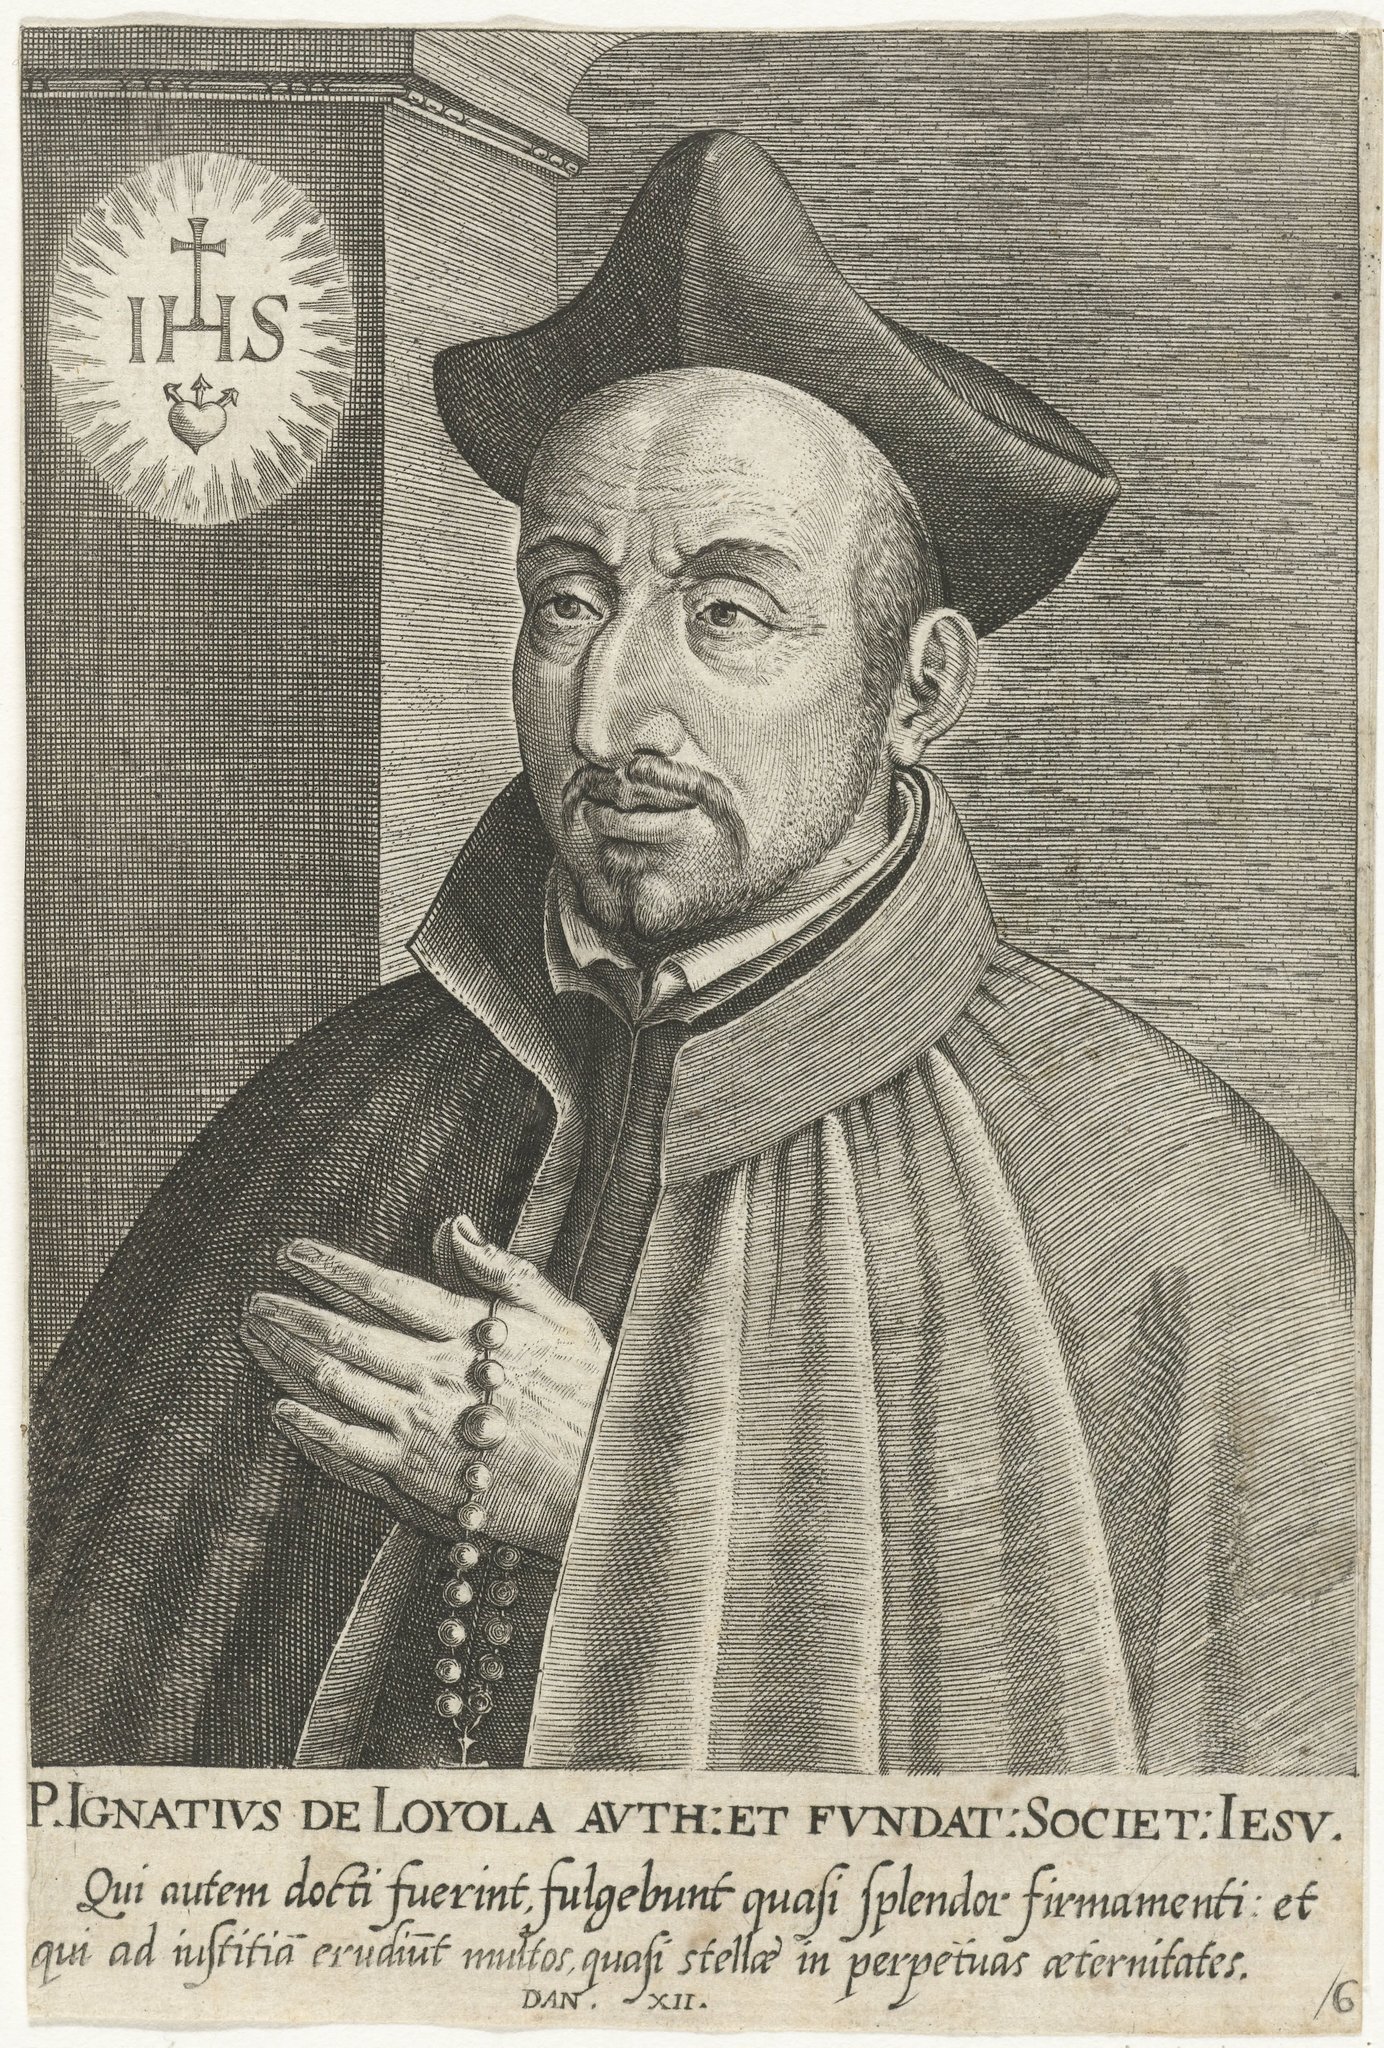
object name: print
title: Icones Institutorum sex illustrium in Christiana religione ordinum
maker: dominicus custos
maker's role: print maker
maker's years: 1560-1615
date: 1579-1615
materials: paper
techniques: engraving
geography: augsburg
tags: the founder of the jesuit order, ignatius of loyola; possible attributes: book (with 'ad majorem dei gloriam'), demon, dragon under feet, flames, flaming heart, globe, ihs monogram, skull (with crown), tears in eyes, torch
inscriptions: collector's mark: Lugt 240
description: De heilige Ignatius van Loyola, stichter van de Jezuïeten orde, met een rozenkrans in zijn hand. Links in de hoek het IHS-monogram met hart en kruis, het symbool van de Jezuïeten.